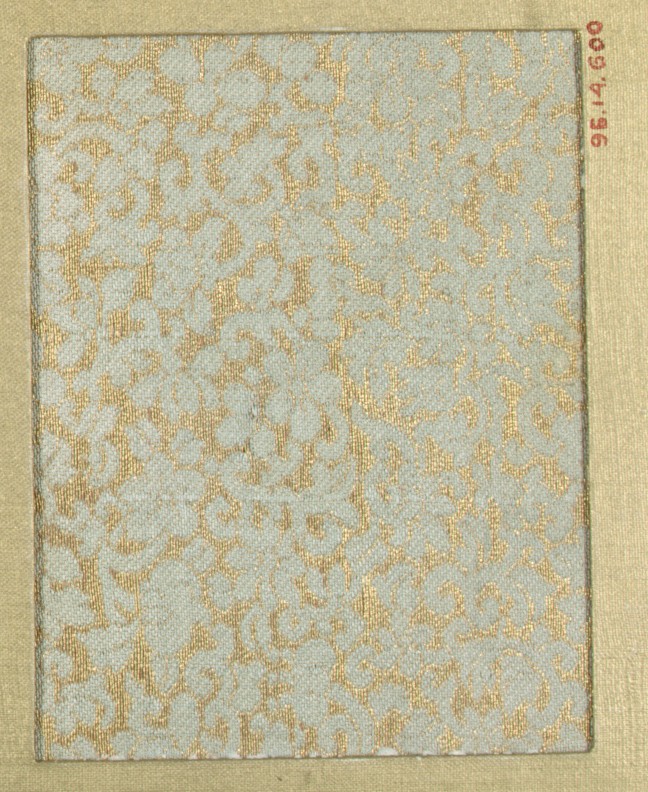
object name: piece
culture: japanese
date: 1701-1900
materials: silk